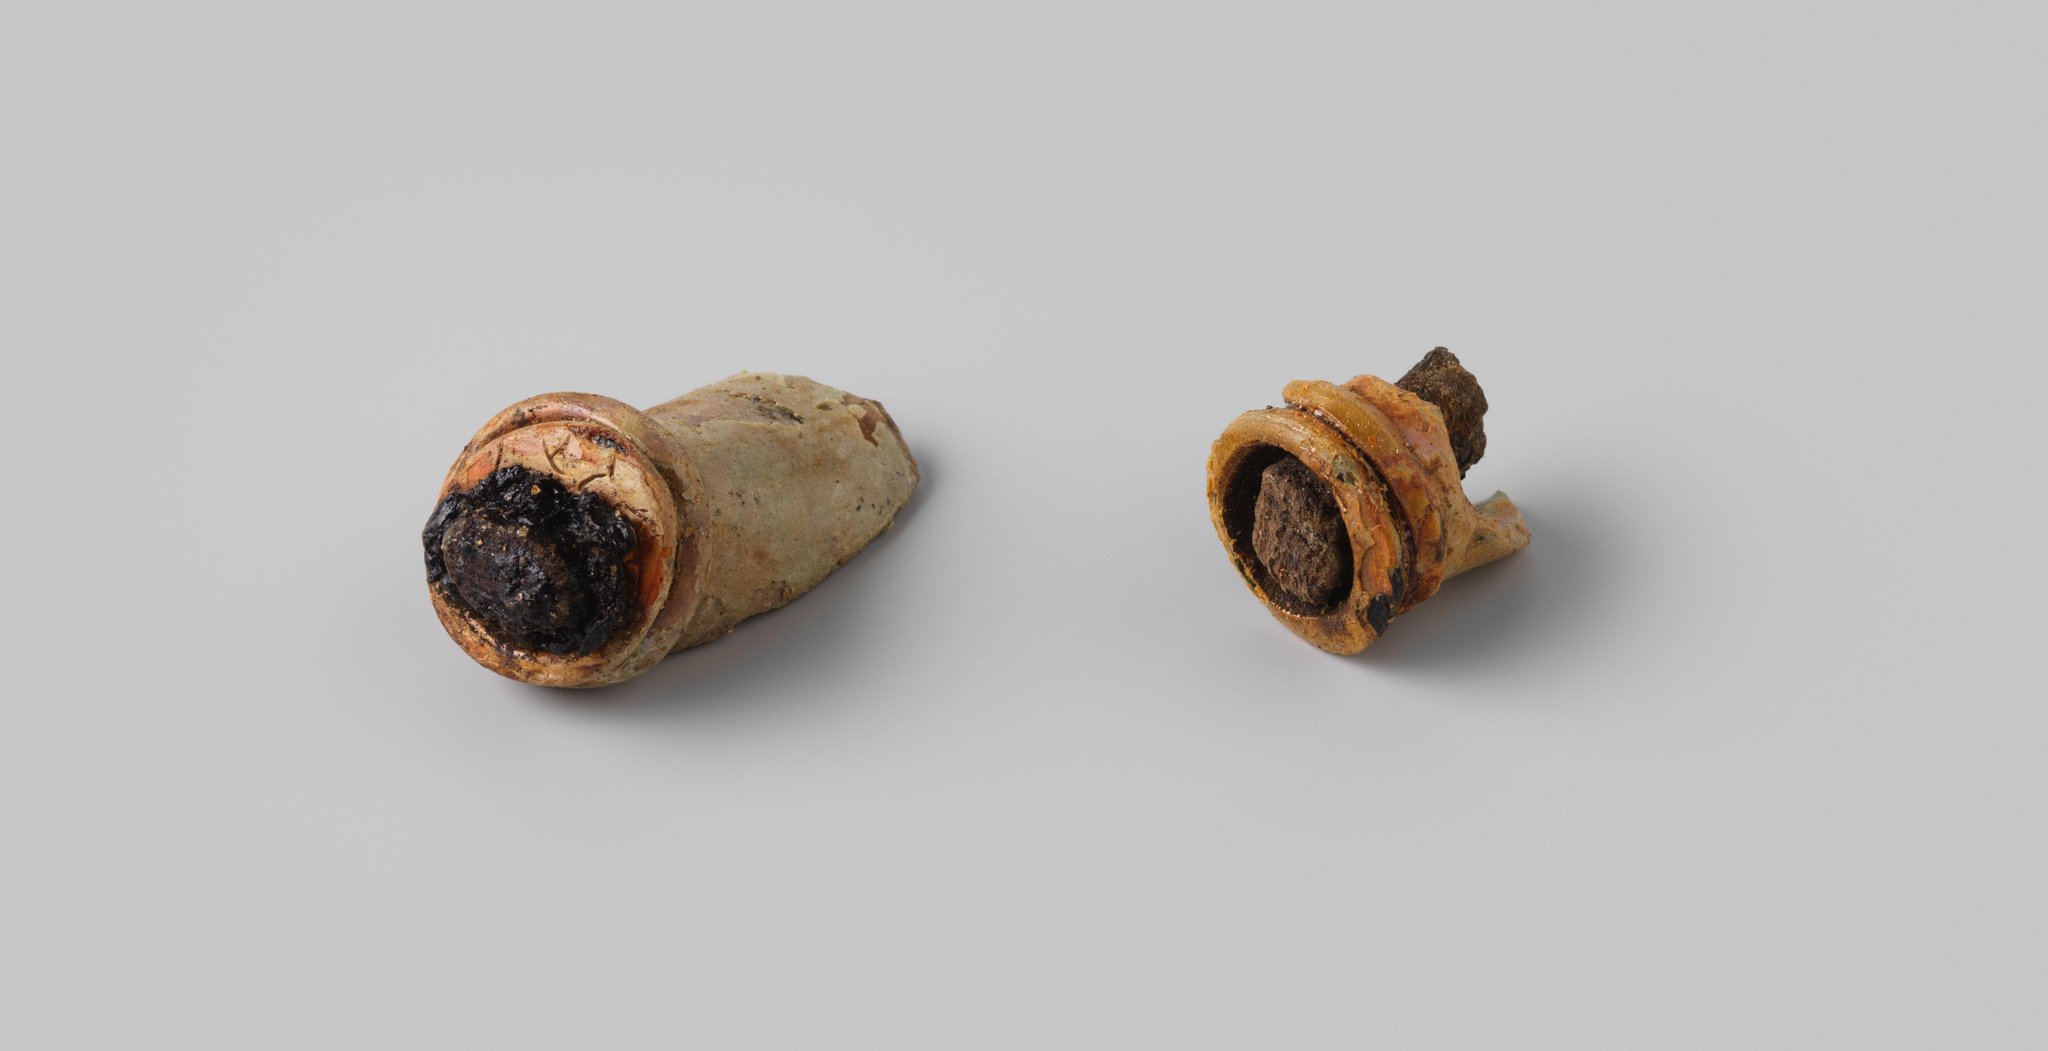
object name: wine bottle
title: Halzen met kurk van een wijnfles uit het wrak van de Oost-Indiëvaarder Hollandia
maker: Anonymous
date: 1700-1743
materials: cork, glass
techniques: green glass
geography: netherlands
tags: verenigde oostindische compagnie, hollandia (schip), annet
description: Wine bottle, continental production, neck, onion-shaped bottle or bottle with vertical side; fragm, vs-string rim, cork level with mouth.